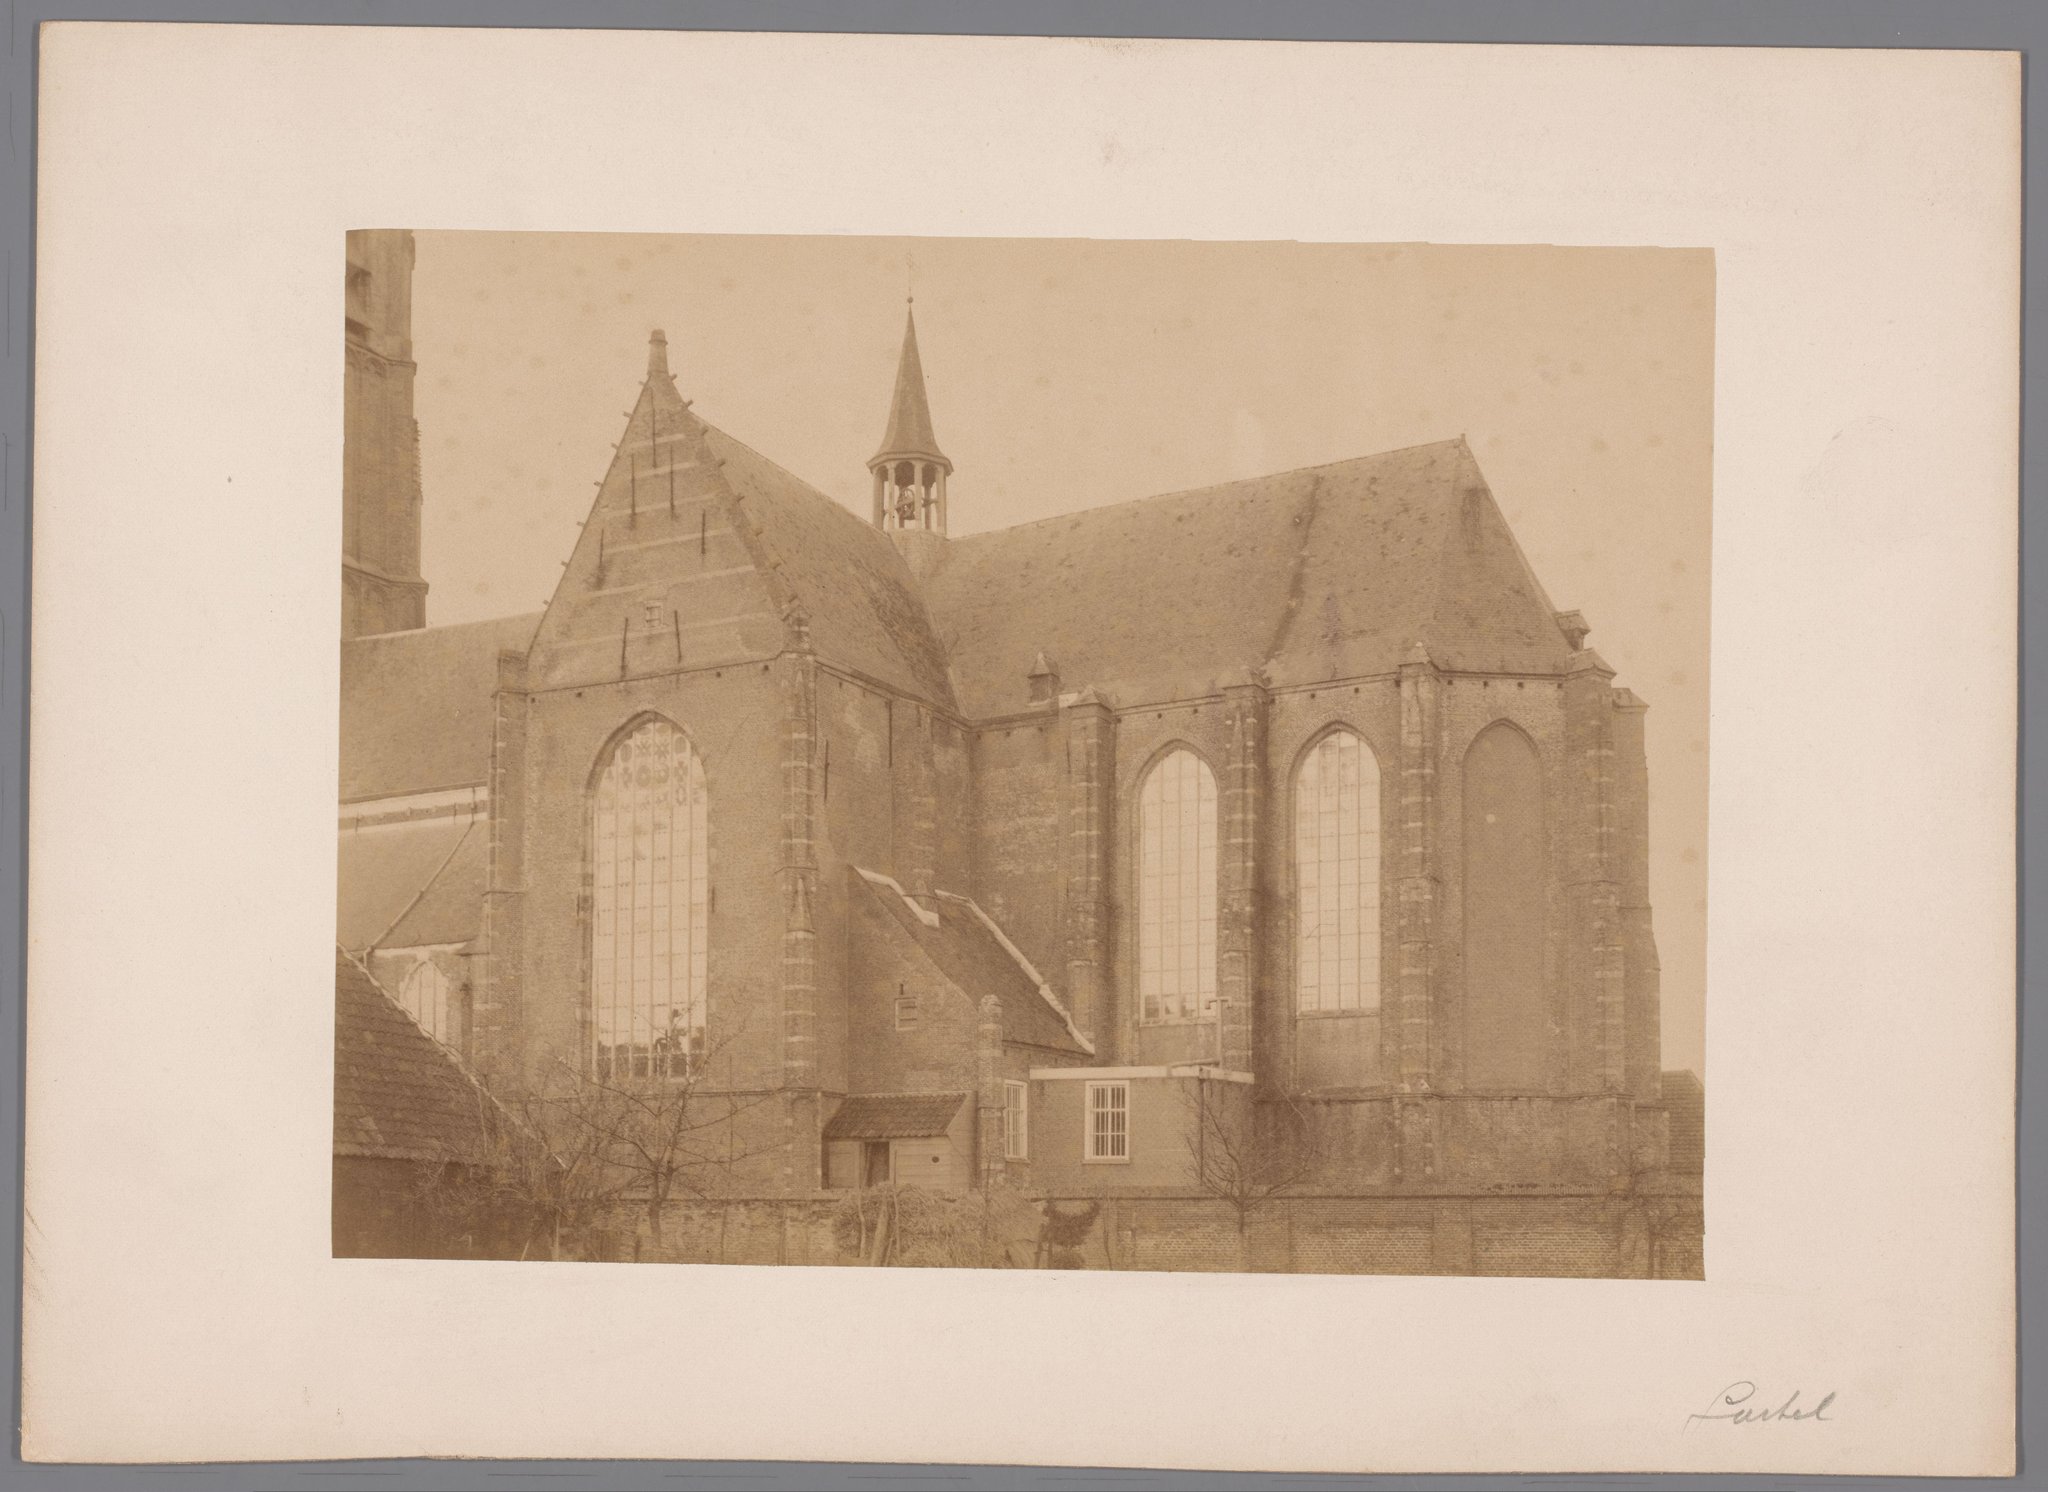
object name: photograph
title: Gezicht op de Sint-Laurentiuskerk te Oud Gastel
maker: anoniem (monumentenzorg)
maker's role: fotograaf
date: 1899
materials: cardboard, photographic support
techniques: albumen print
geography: oud gastel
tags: parts of church exterior and annexes: choir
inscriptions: annotation: ‘Gastel’, annotation: ‘R.K. Kerk te Gastel (N.B.)/ Het koor van de zuidzijde gezien/ Jan 99’